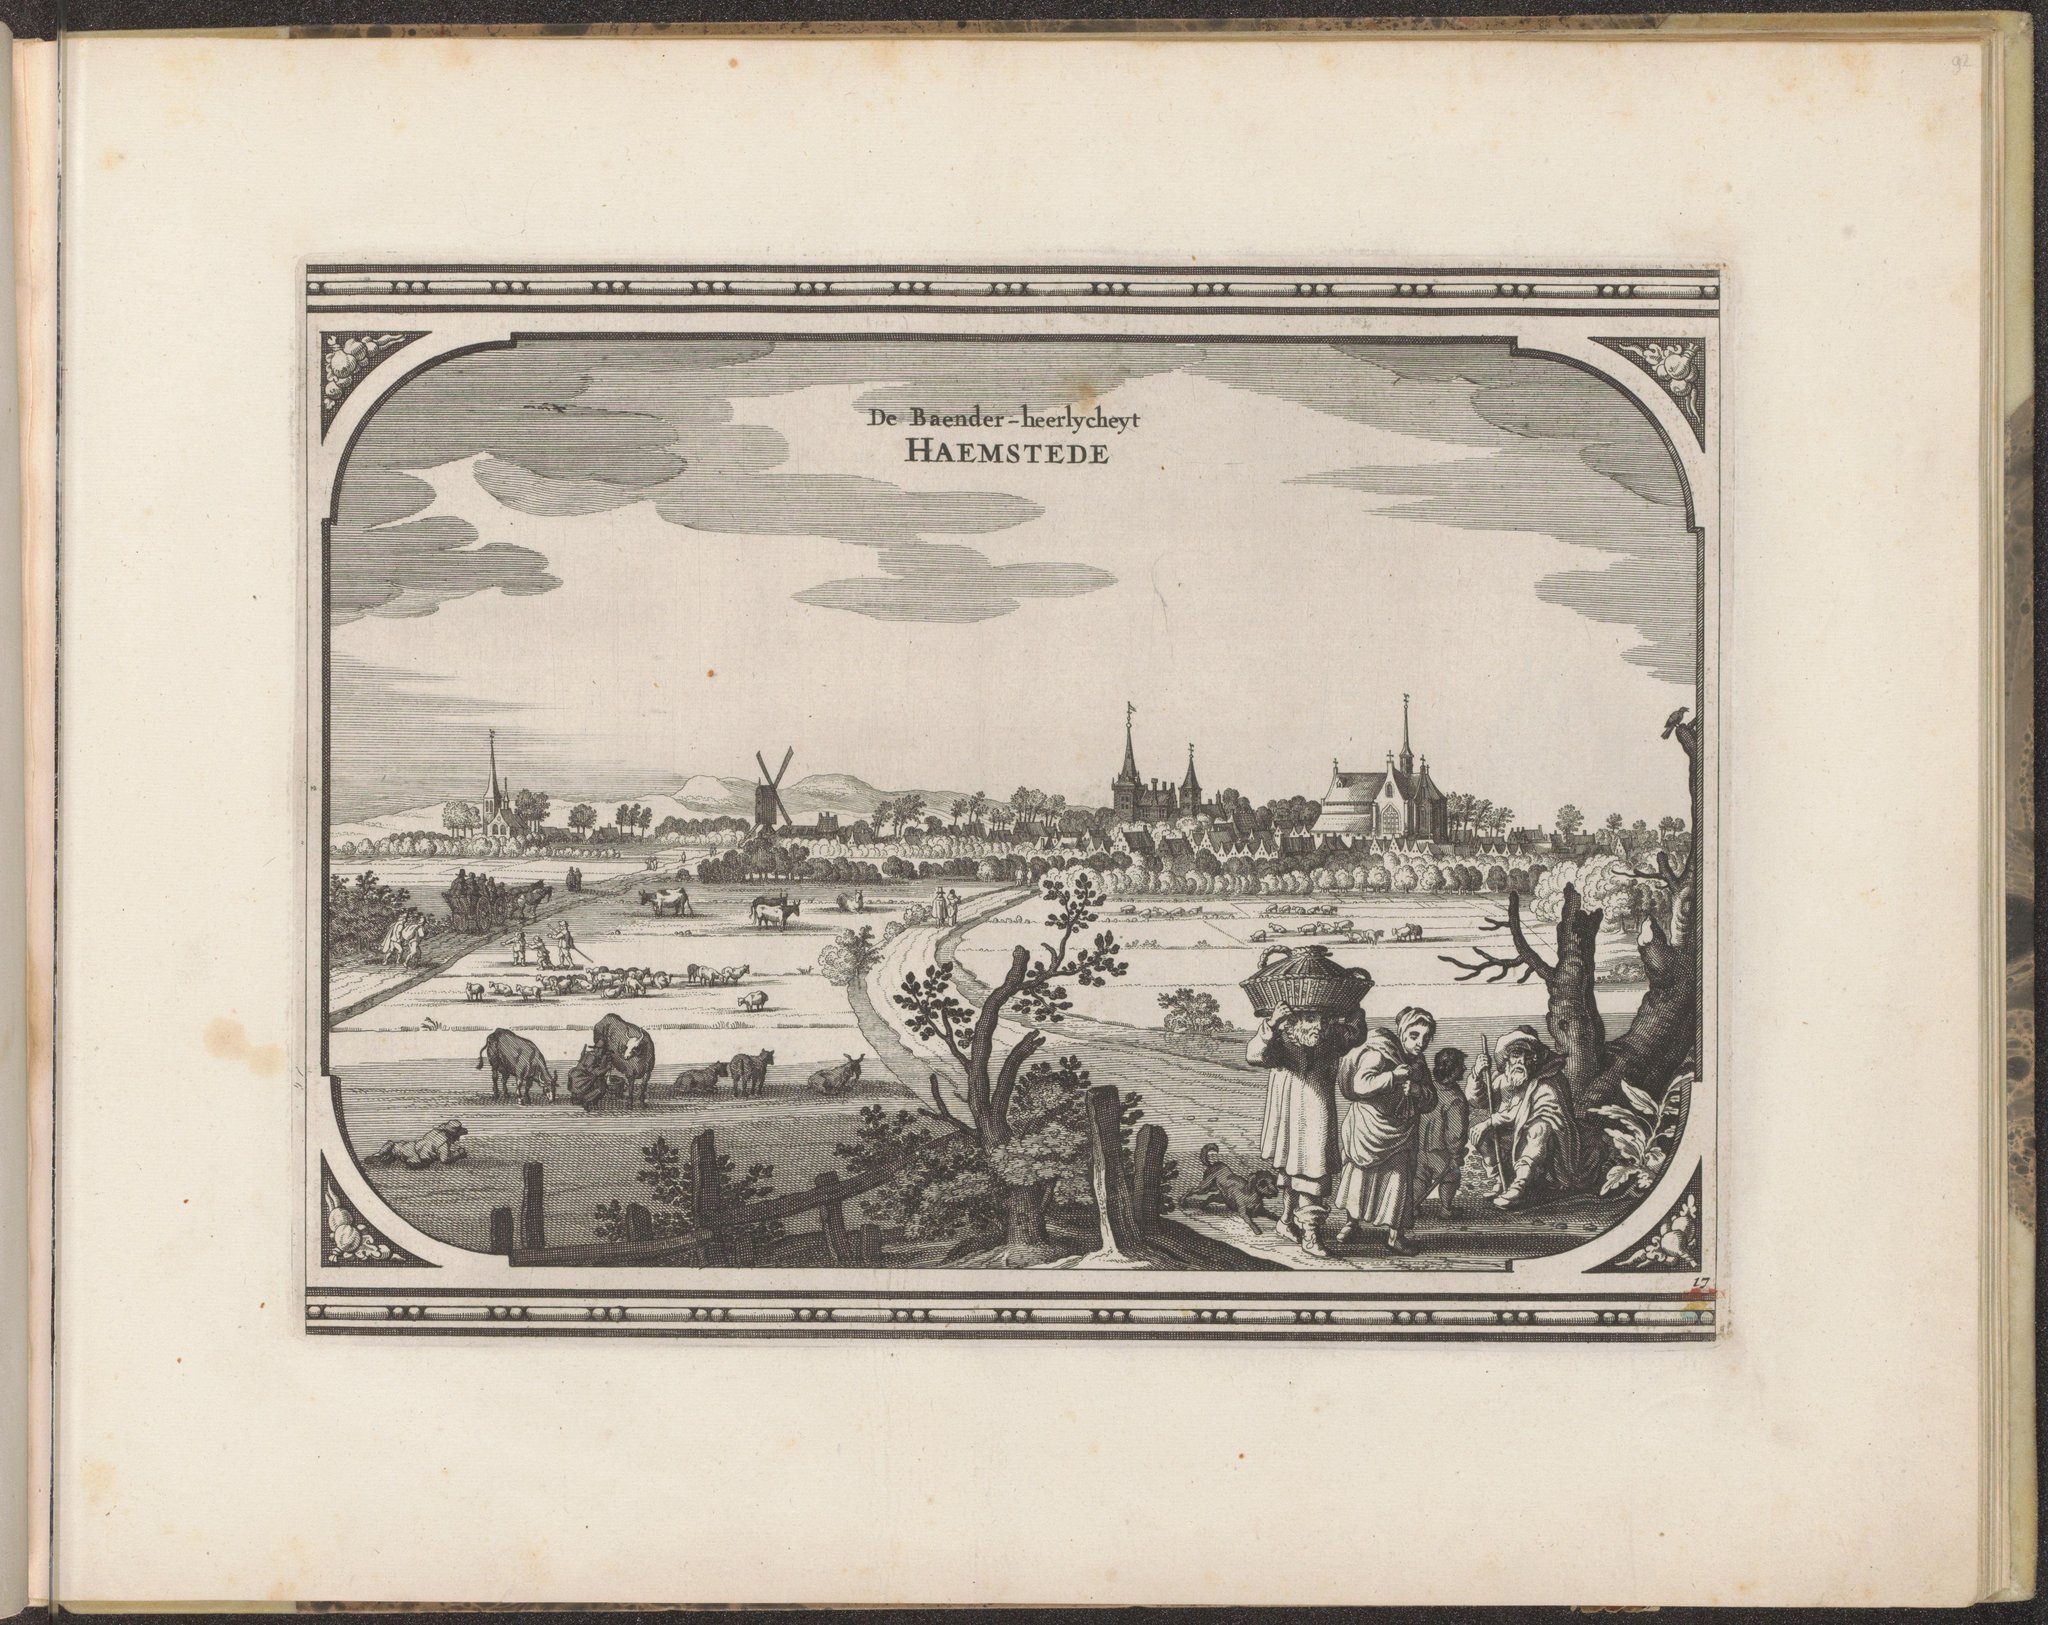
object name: print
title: Speculum Zelandiae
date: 1662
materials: paper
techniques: etching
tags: city-view, and landscape with man-made constructions, carrying something, cattle, four-wheeled, animal-drawn vehicle, e.g.: cab, carriage, coach, milking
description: Gezicht op Haamstede in Zeeland en het omliggende land met vee. Op de voorgrond rechts sjouwt een man een mand op zijn hoofd. De vrouw naast hem heeft een zak over haar schouder. Bij de boom zit een oude man. Links onder meer een wagen voortgetrokken door twee paarden. In het weiland wordt een koe gemolken. De prent maakt deel uit van een album.